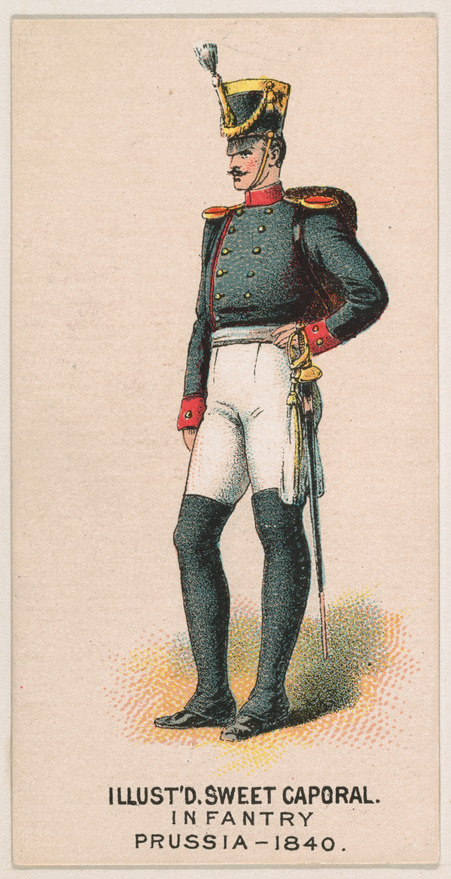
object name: print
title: Infantry, Prussia, 1840, from the Military Series (N224) issued by Kinney Tobacco Company to promote Sweet Caporal Cigarettes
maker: kinney brothers tobacco company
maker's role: publisher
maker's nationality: american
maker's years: 1869-2011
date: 1888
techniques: color lithograph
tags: military,swords,men,profiles